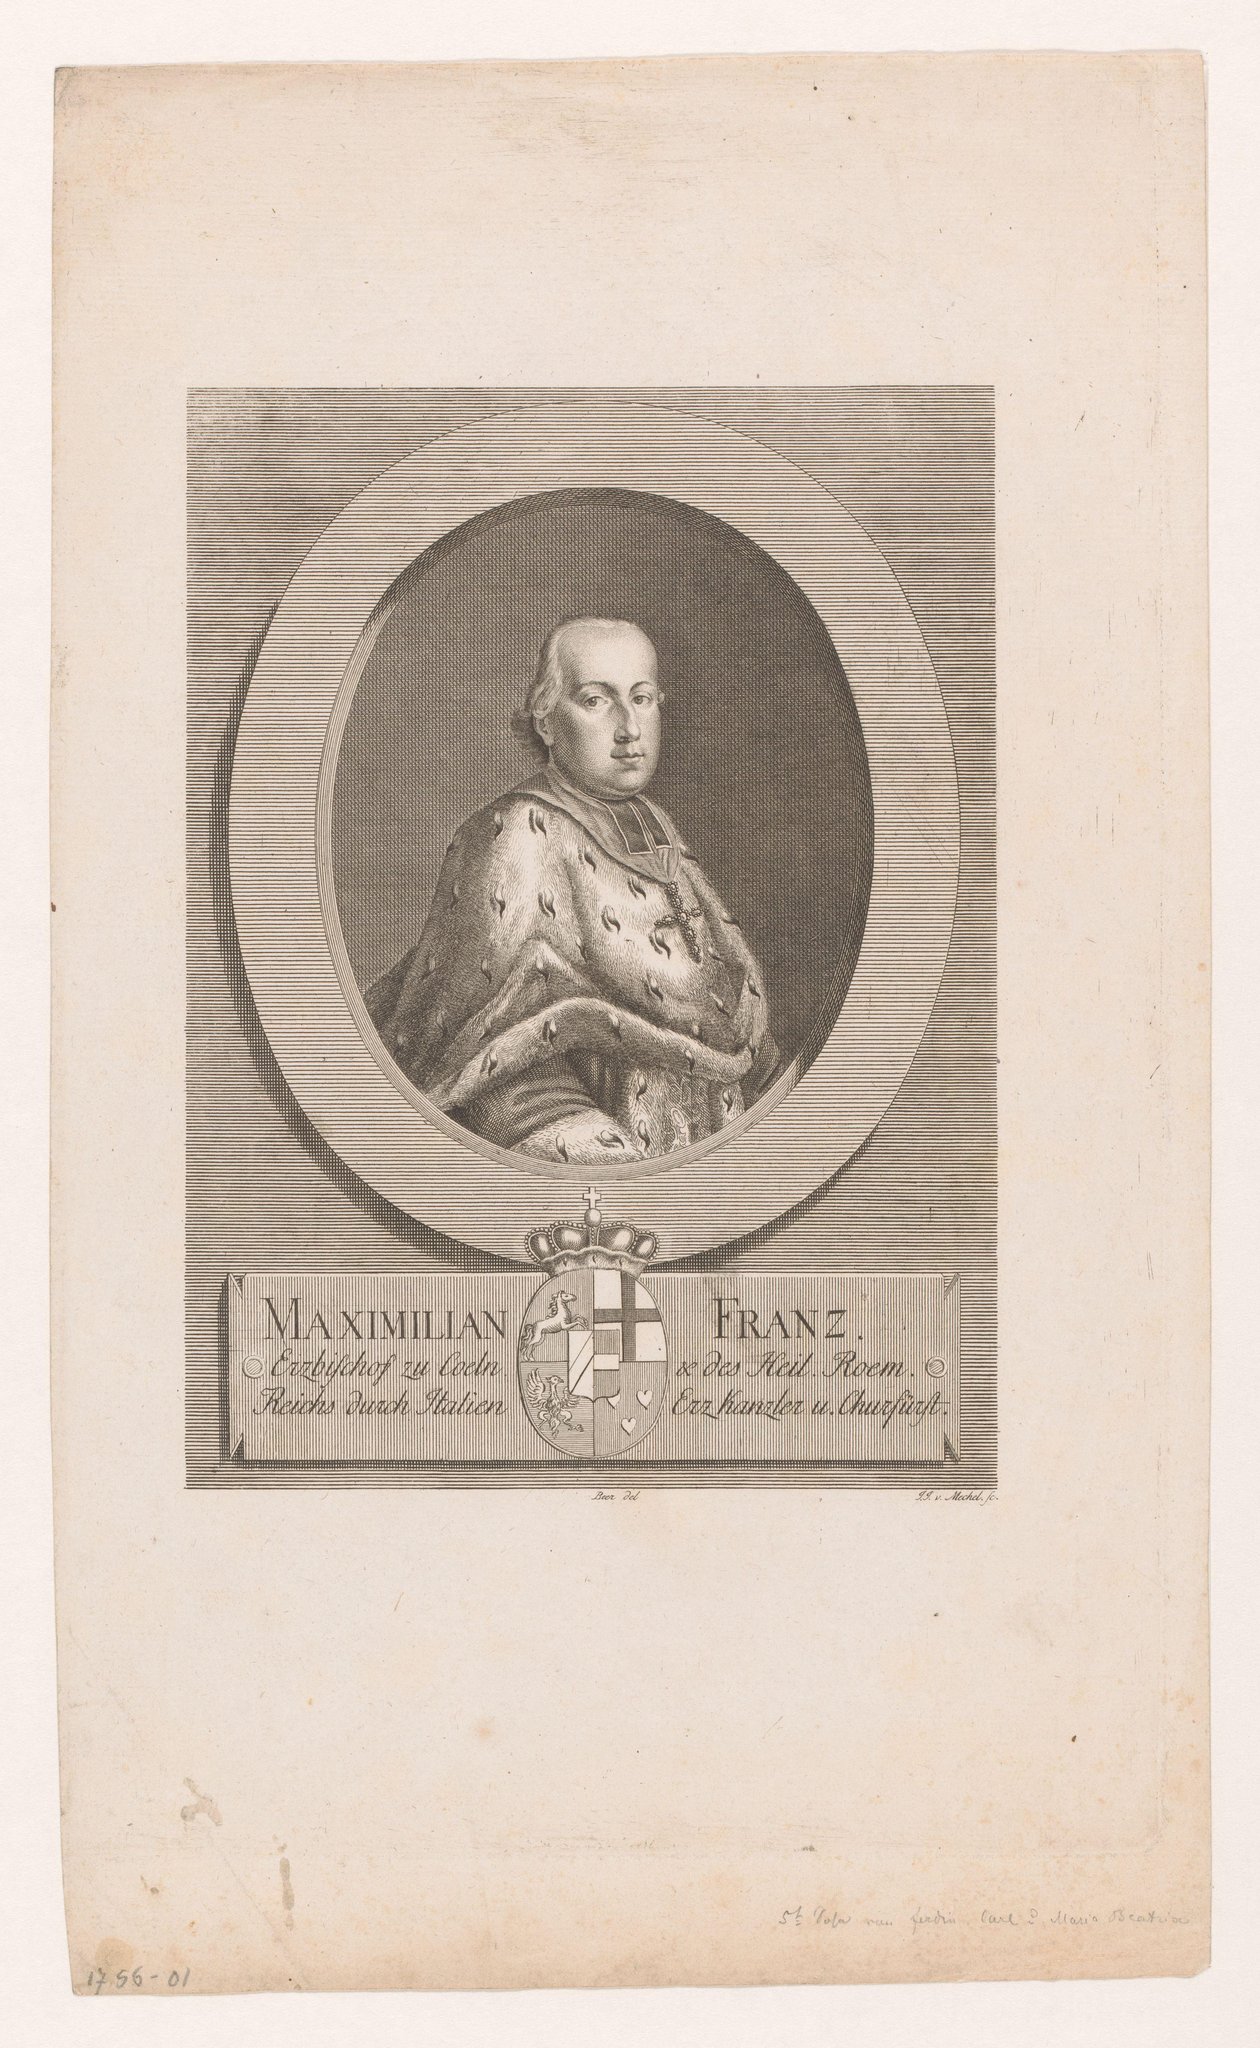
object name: print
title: Portret van Maximiliaan Franz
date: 1774-1816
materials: paper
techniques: engraving, etching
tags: vienna, historical persons, armorial bearing, heraldry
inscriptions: collector's mark: Lugt 2228